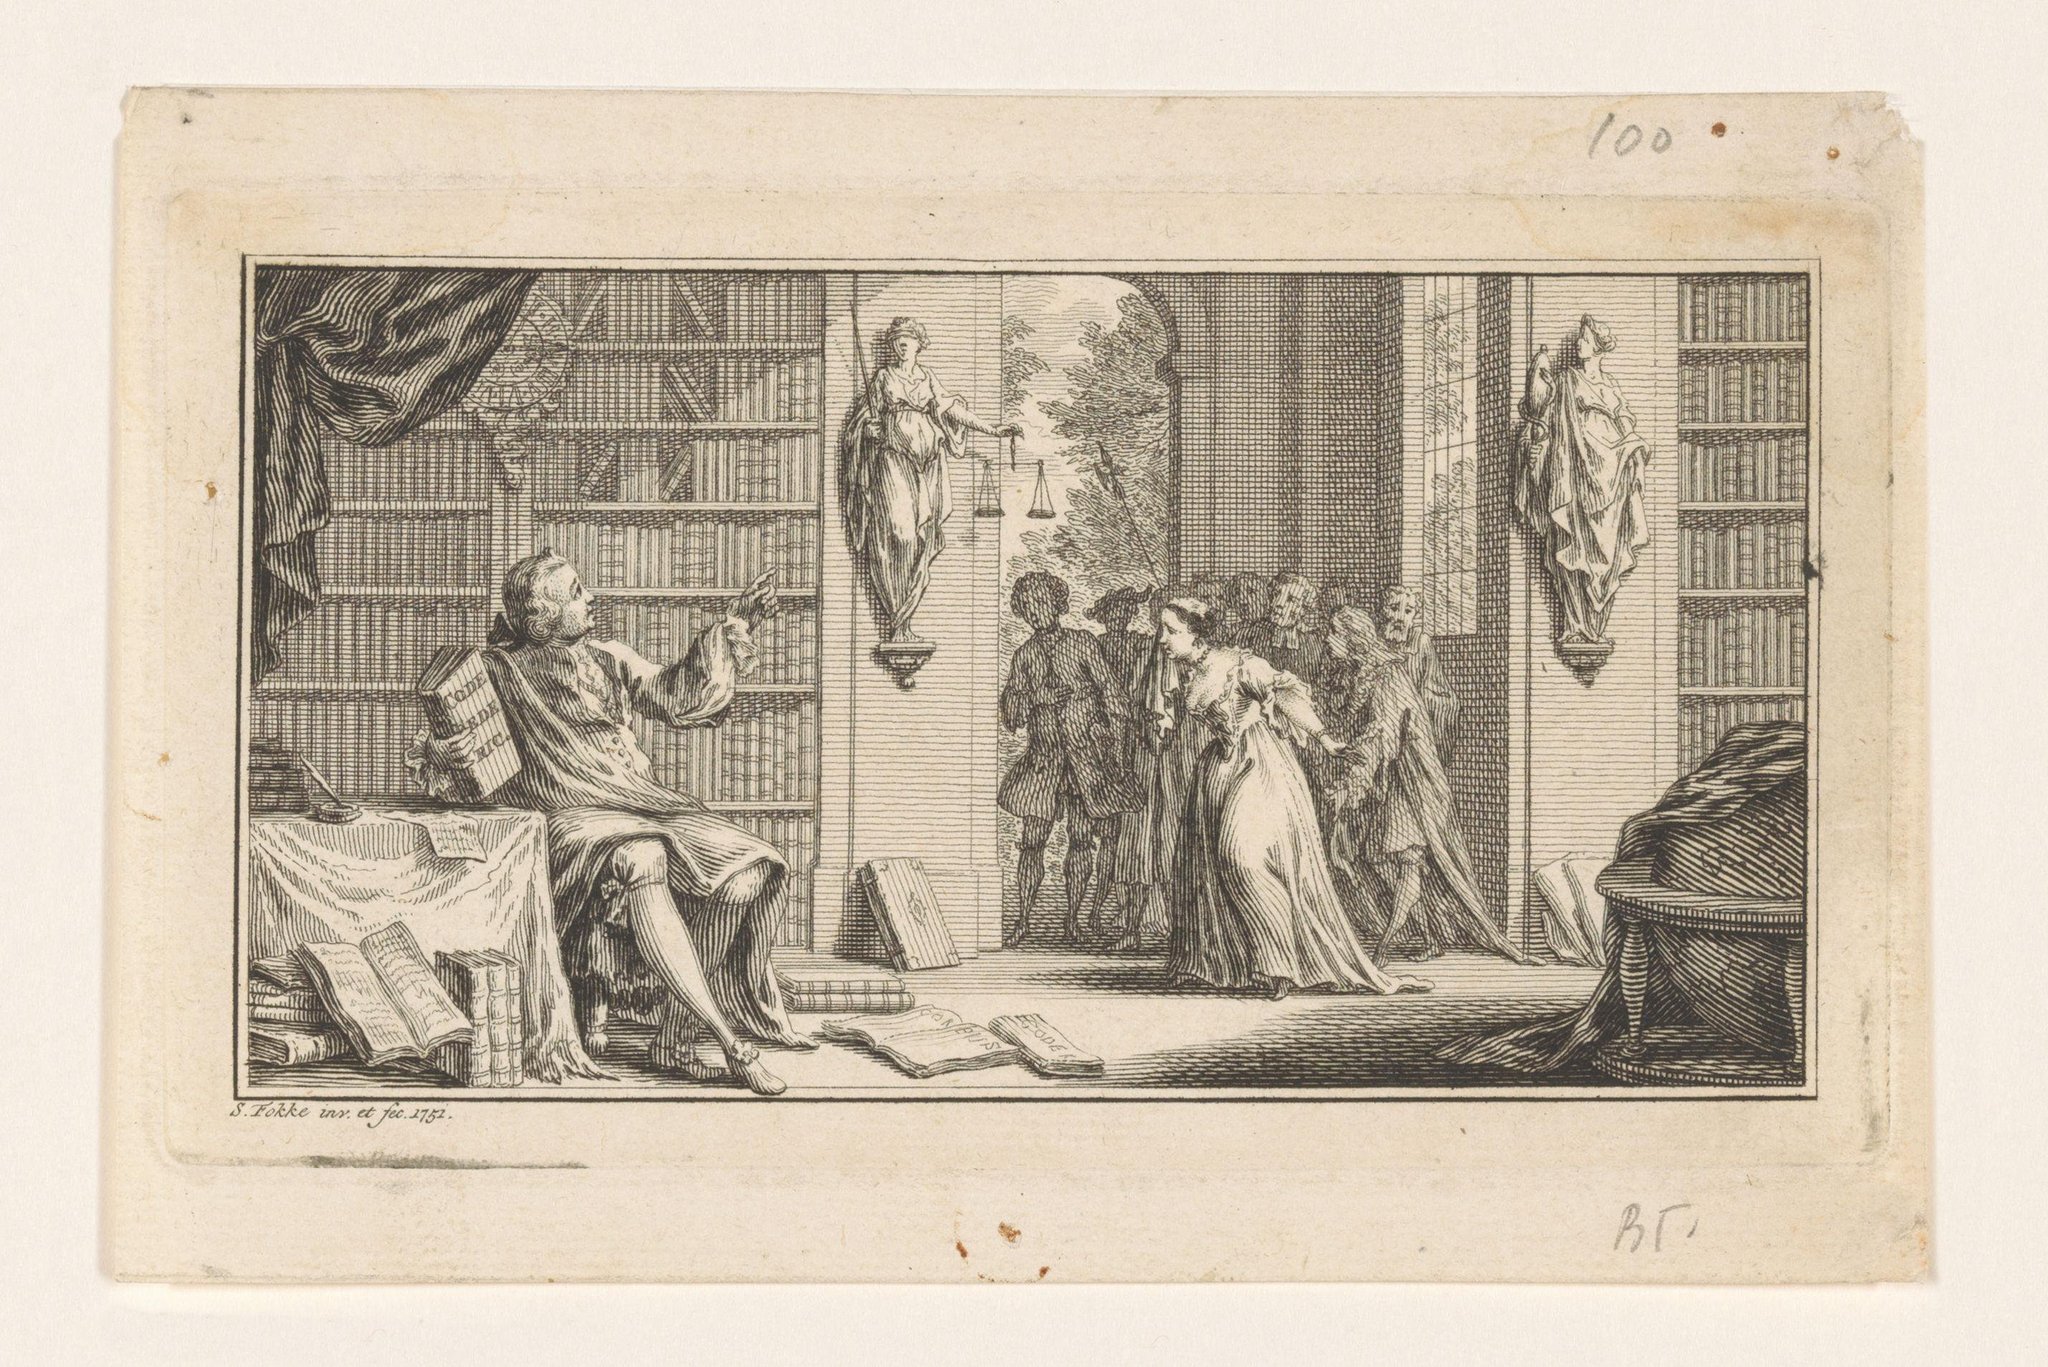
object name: print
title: Man in bibliotheek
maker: simon fokke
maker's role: draughtsman, print maker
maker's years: 1712-1784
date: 1751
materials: paper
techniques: etching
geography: amsterdam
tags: justice, 'justitia'; 'giustitia divina' (ripa) ~ one of the four cardinal virtues, study; 'studiolo'; library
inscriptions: collector's mark: Lugt 4779, collector's mark: Lugt 2228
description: Een vrouw wordt door een groep mannen een bibliotheek binnengebracht. Links zit een man met een boek in zijn handen; hij wijst naar een beeld van Vrouwe Justitia.